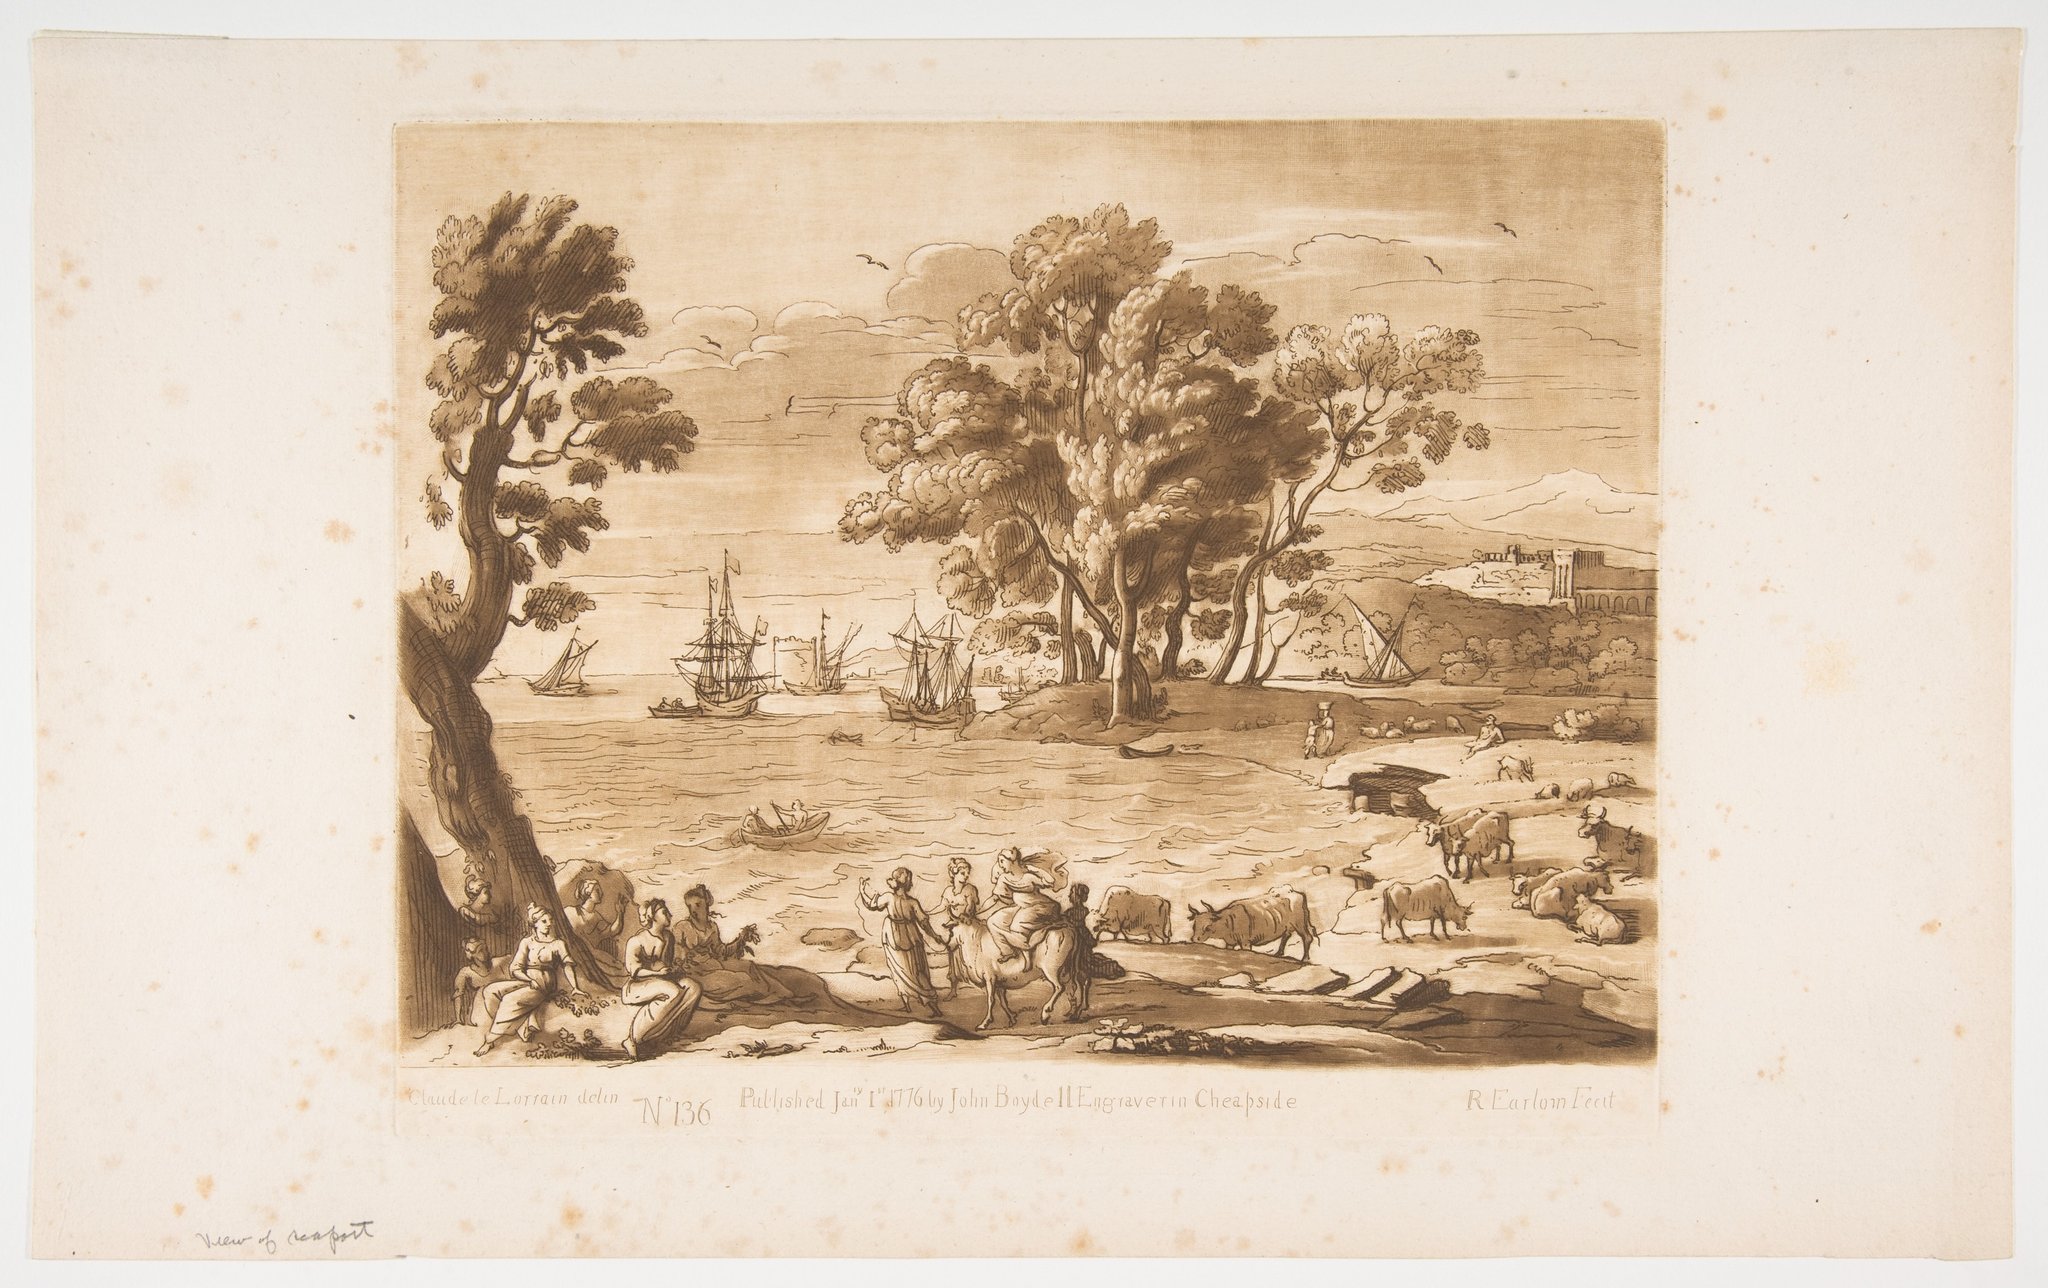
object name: print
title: Rape of Europa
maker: richard earlom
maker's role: engraver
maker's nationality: british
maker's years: 1743-1822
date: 1776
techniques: etching, mezzotint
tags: human figures,animals,europa,ships